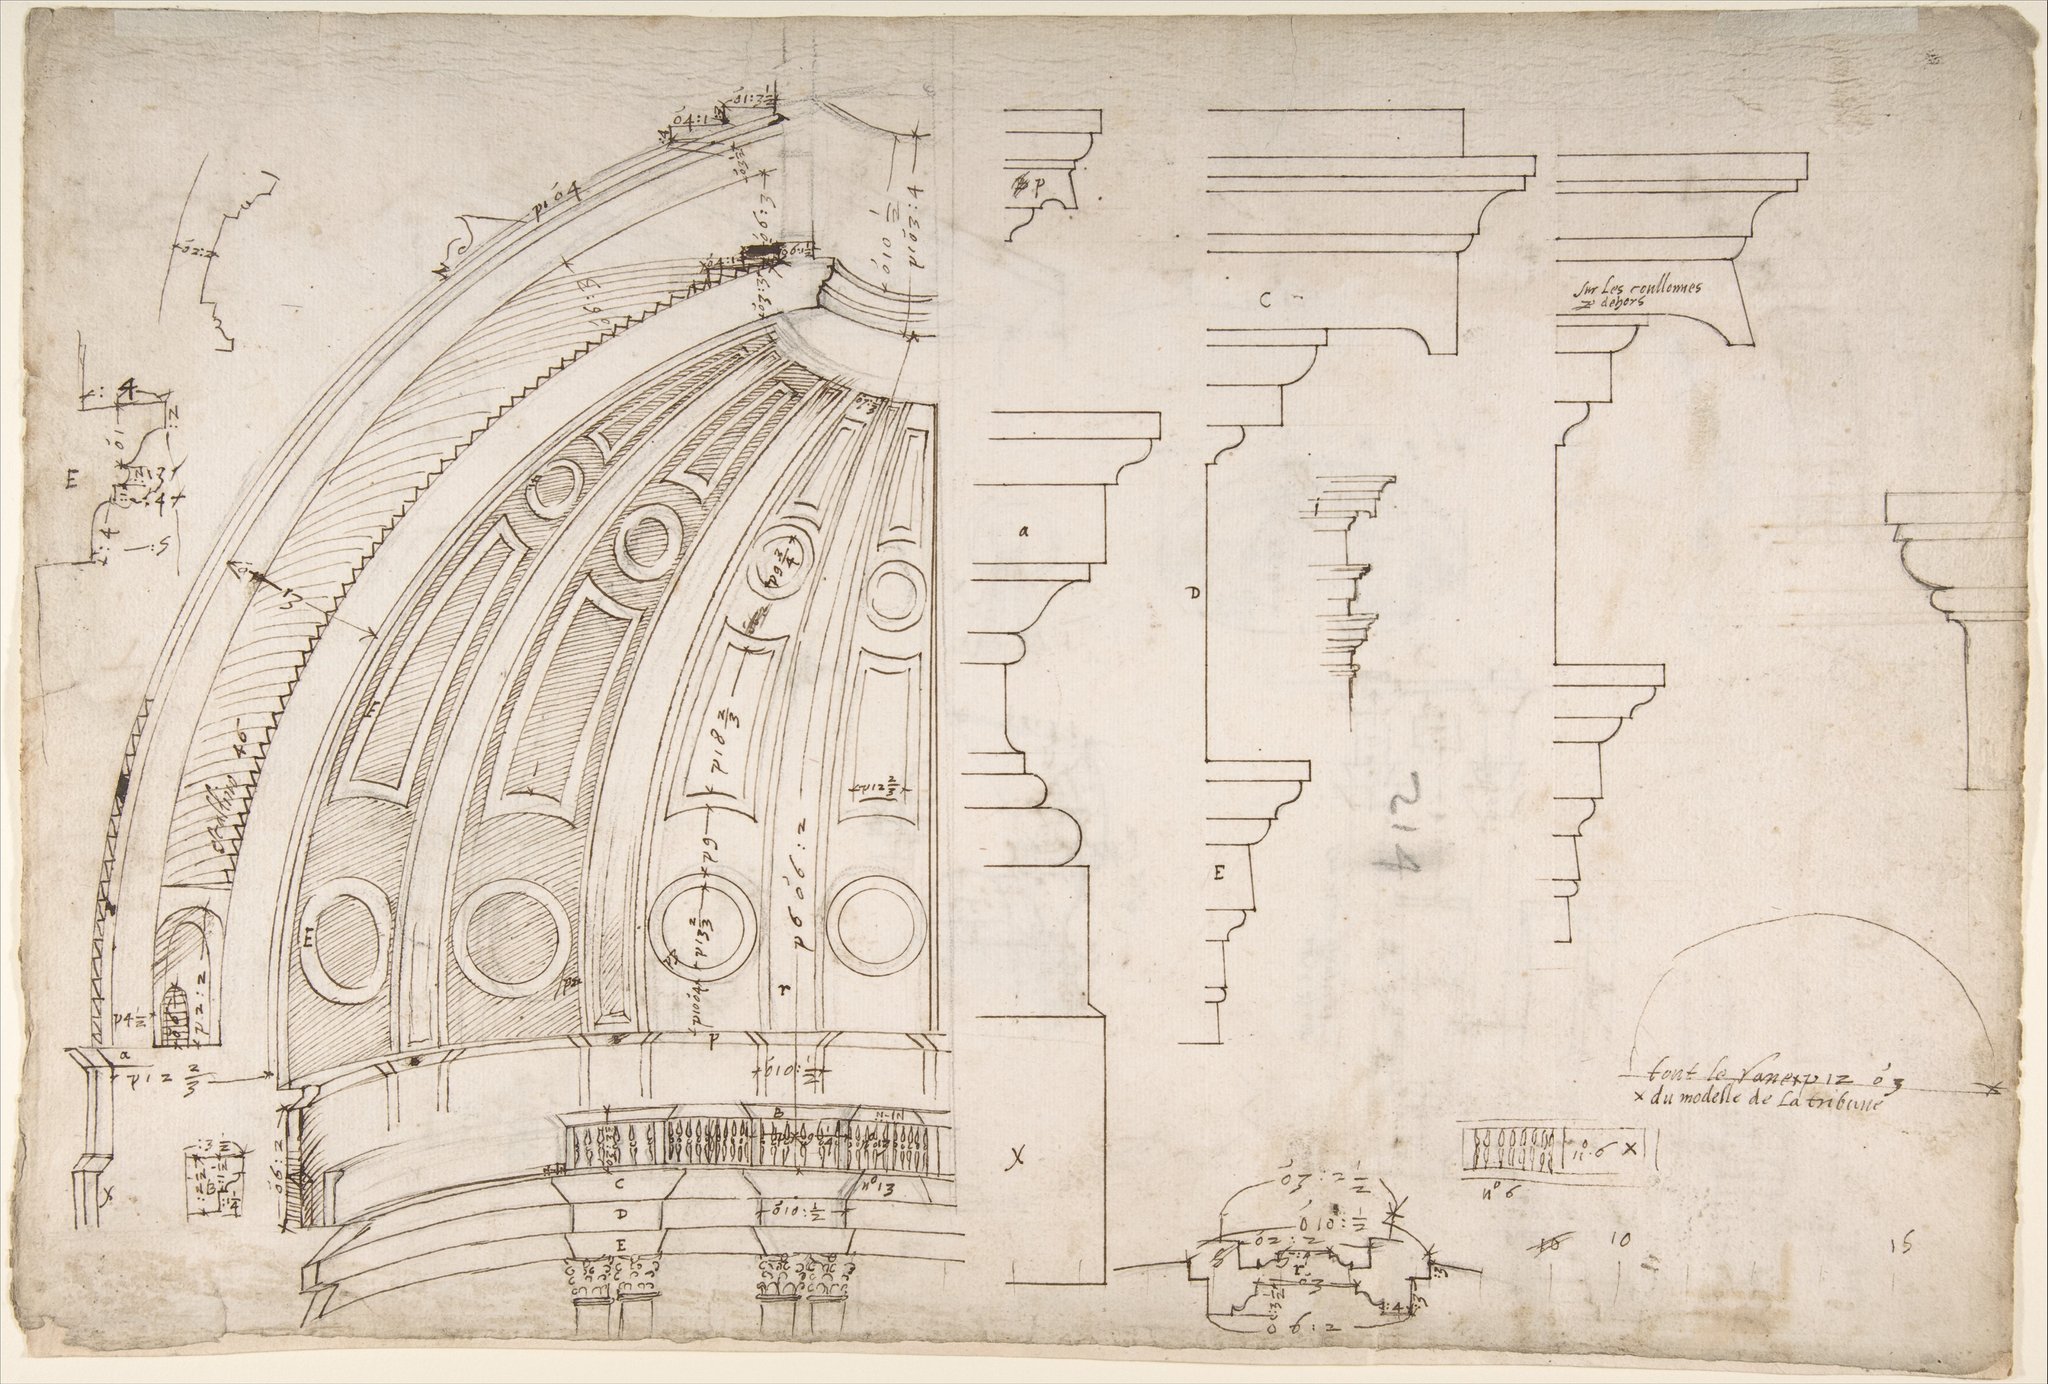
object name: drawing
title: St. Peter's, dome and drum, interior section and elevation, and labeled details (recto); St. Peter's, moulding profiles, details (verso)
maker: etienne dupérac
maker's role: artist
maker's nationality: french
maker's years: 1535-1604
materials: chalk, ink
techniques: incising, pen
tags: architecture,domes